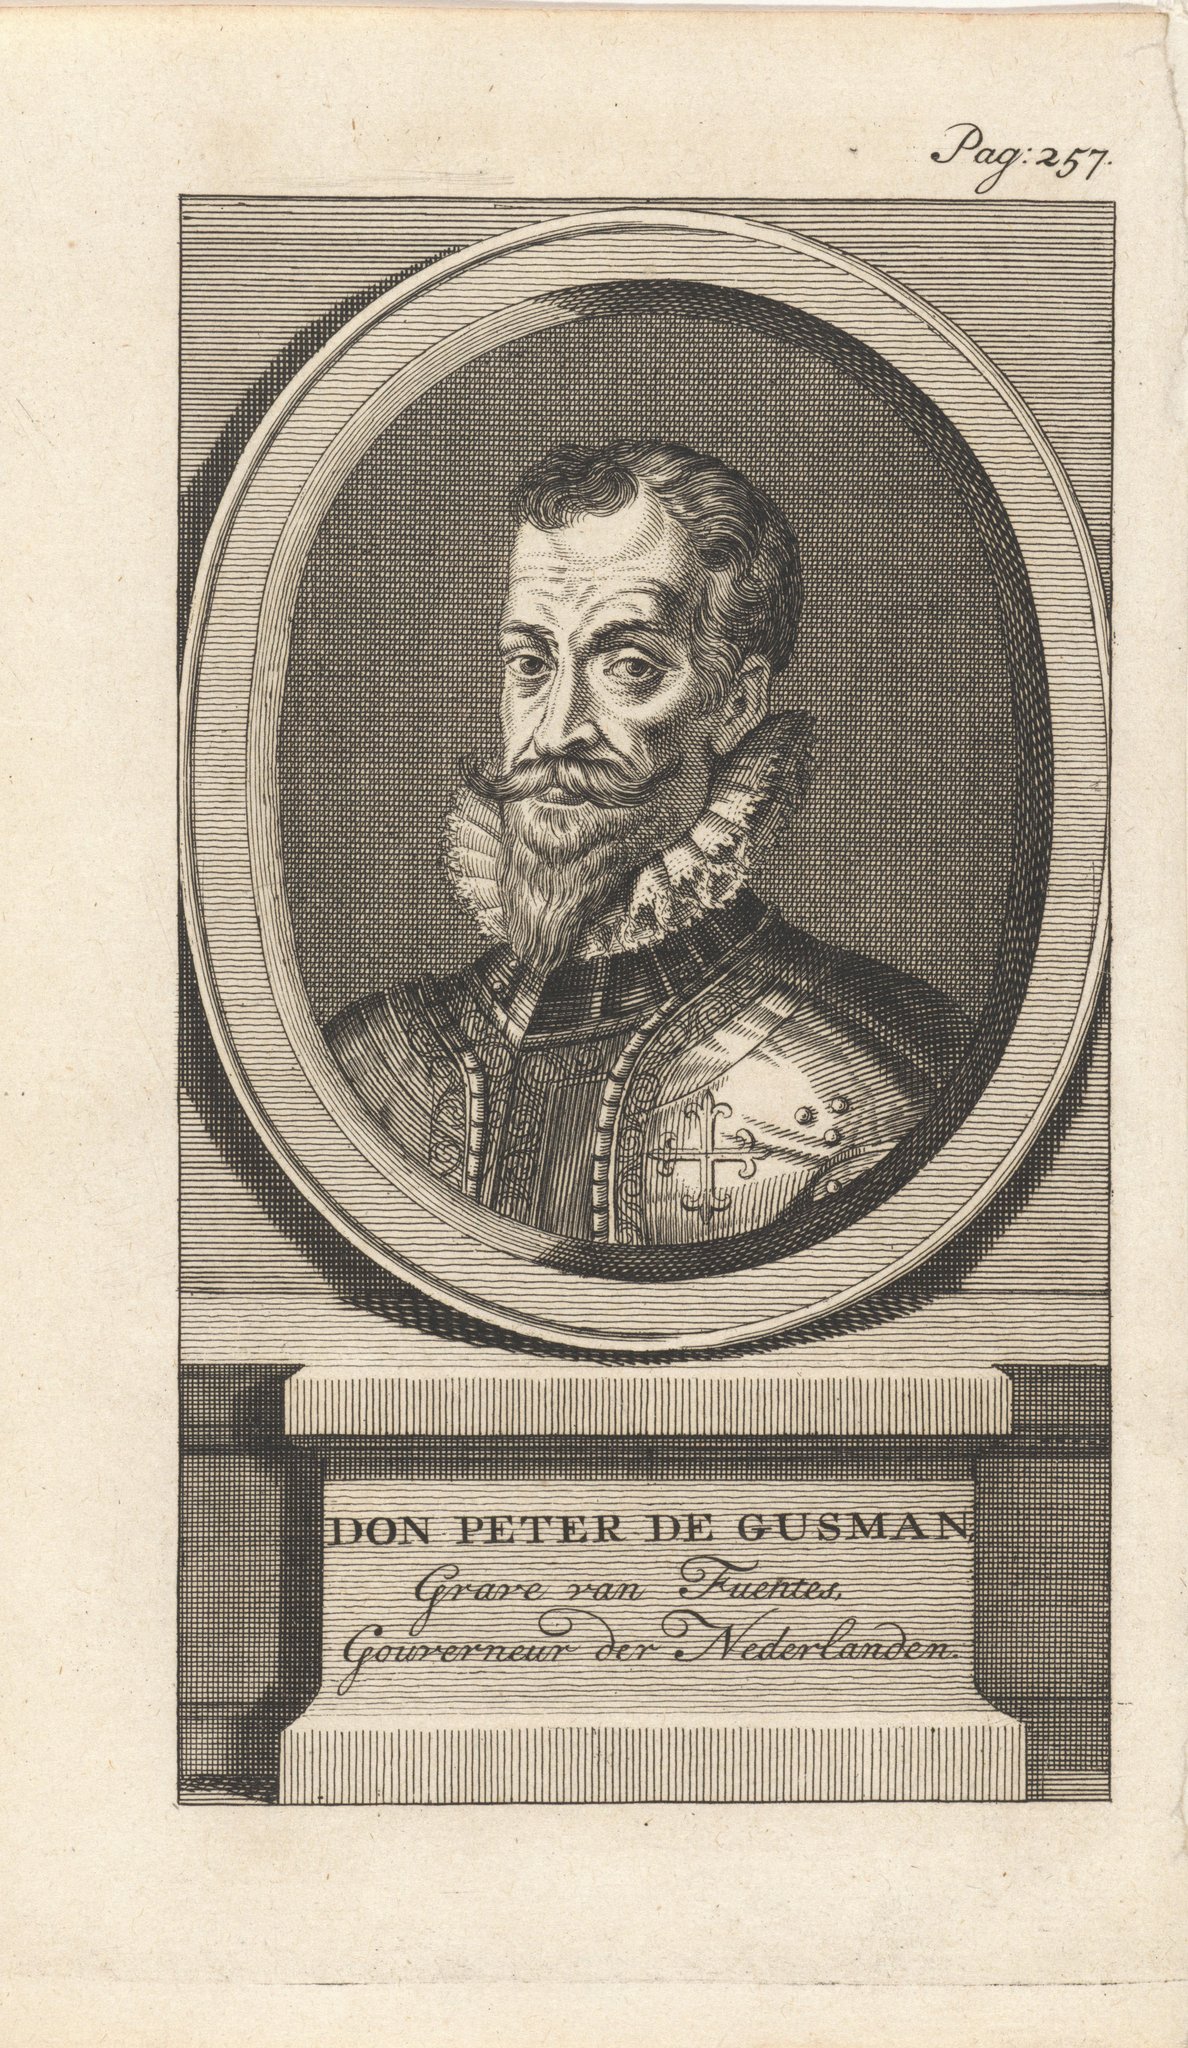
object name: book illustration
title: Portret van Pedro Enriquez de Acevedo, graaf van Fuentes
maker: jan punt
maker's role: draughtsman, print maker, publisher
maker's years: 1711-1779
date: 1786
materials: paper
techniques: engraving, etching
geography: northern netherlands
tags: politician, pedro enríquez de acevedo (count of fuentes), armour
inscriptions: collector's mark: Lugt 2228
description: Deze prent vermoedelijk gebruikt als illustratie in: Meteren, Emanuel van. Oorlogen en geschiedenissen der Nederlanderen en derzelver nabuuren, deel VI, p. 257. Amsterdam: Steven Jacobus Baalde, 1786.